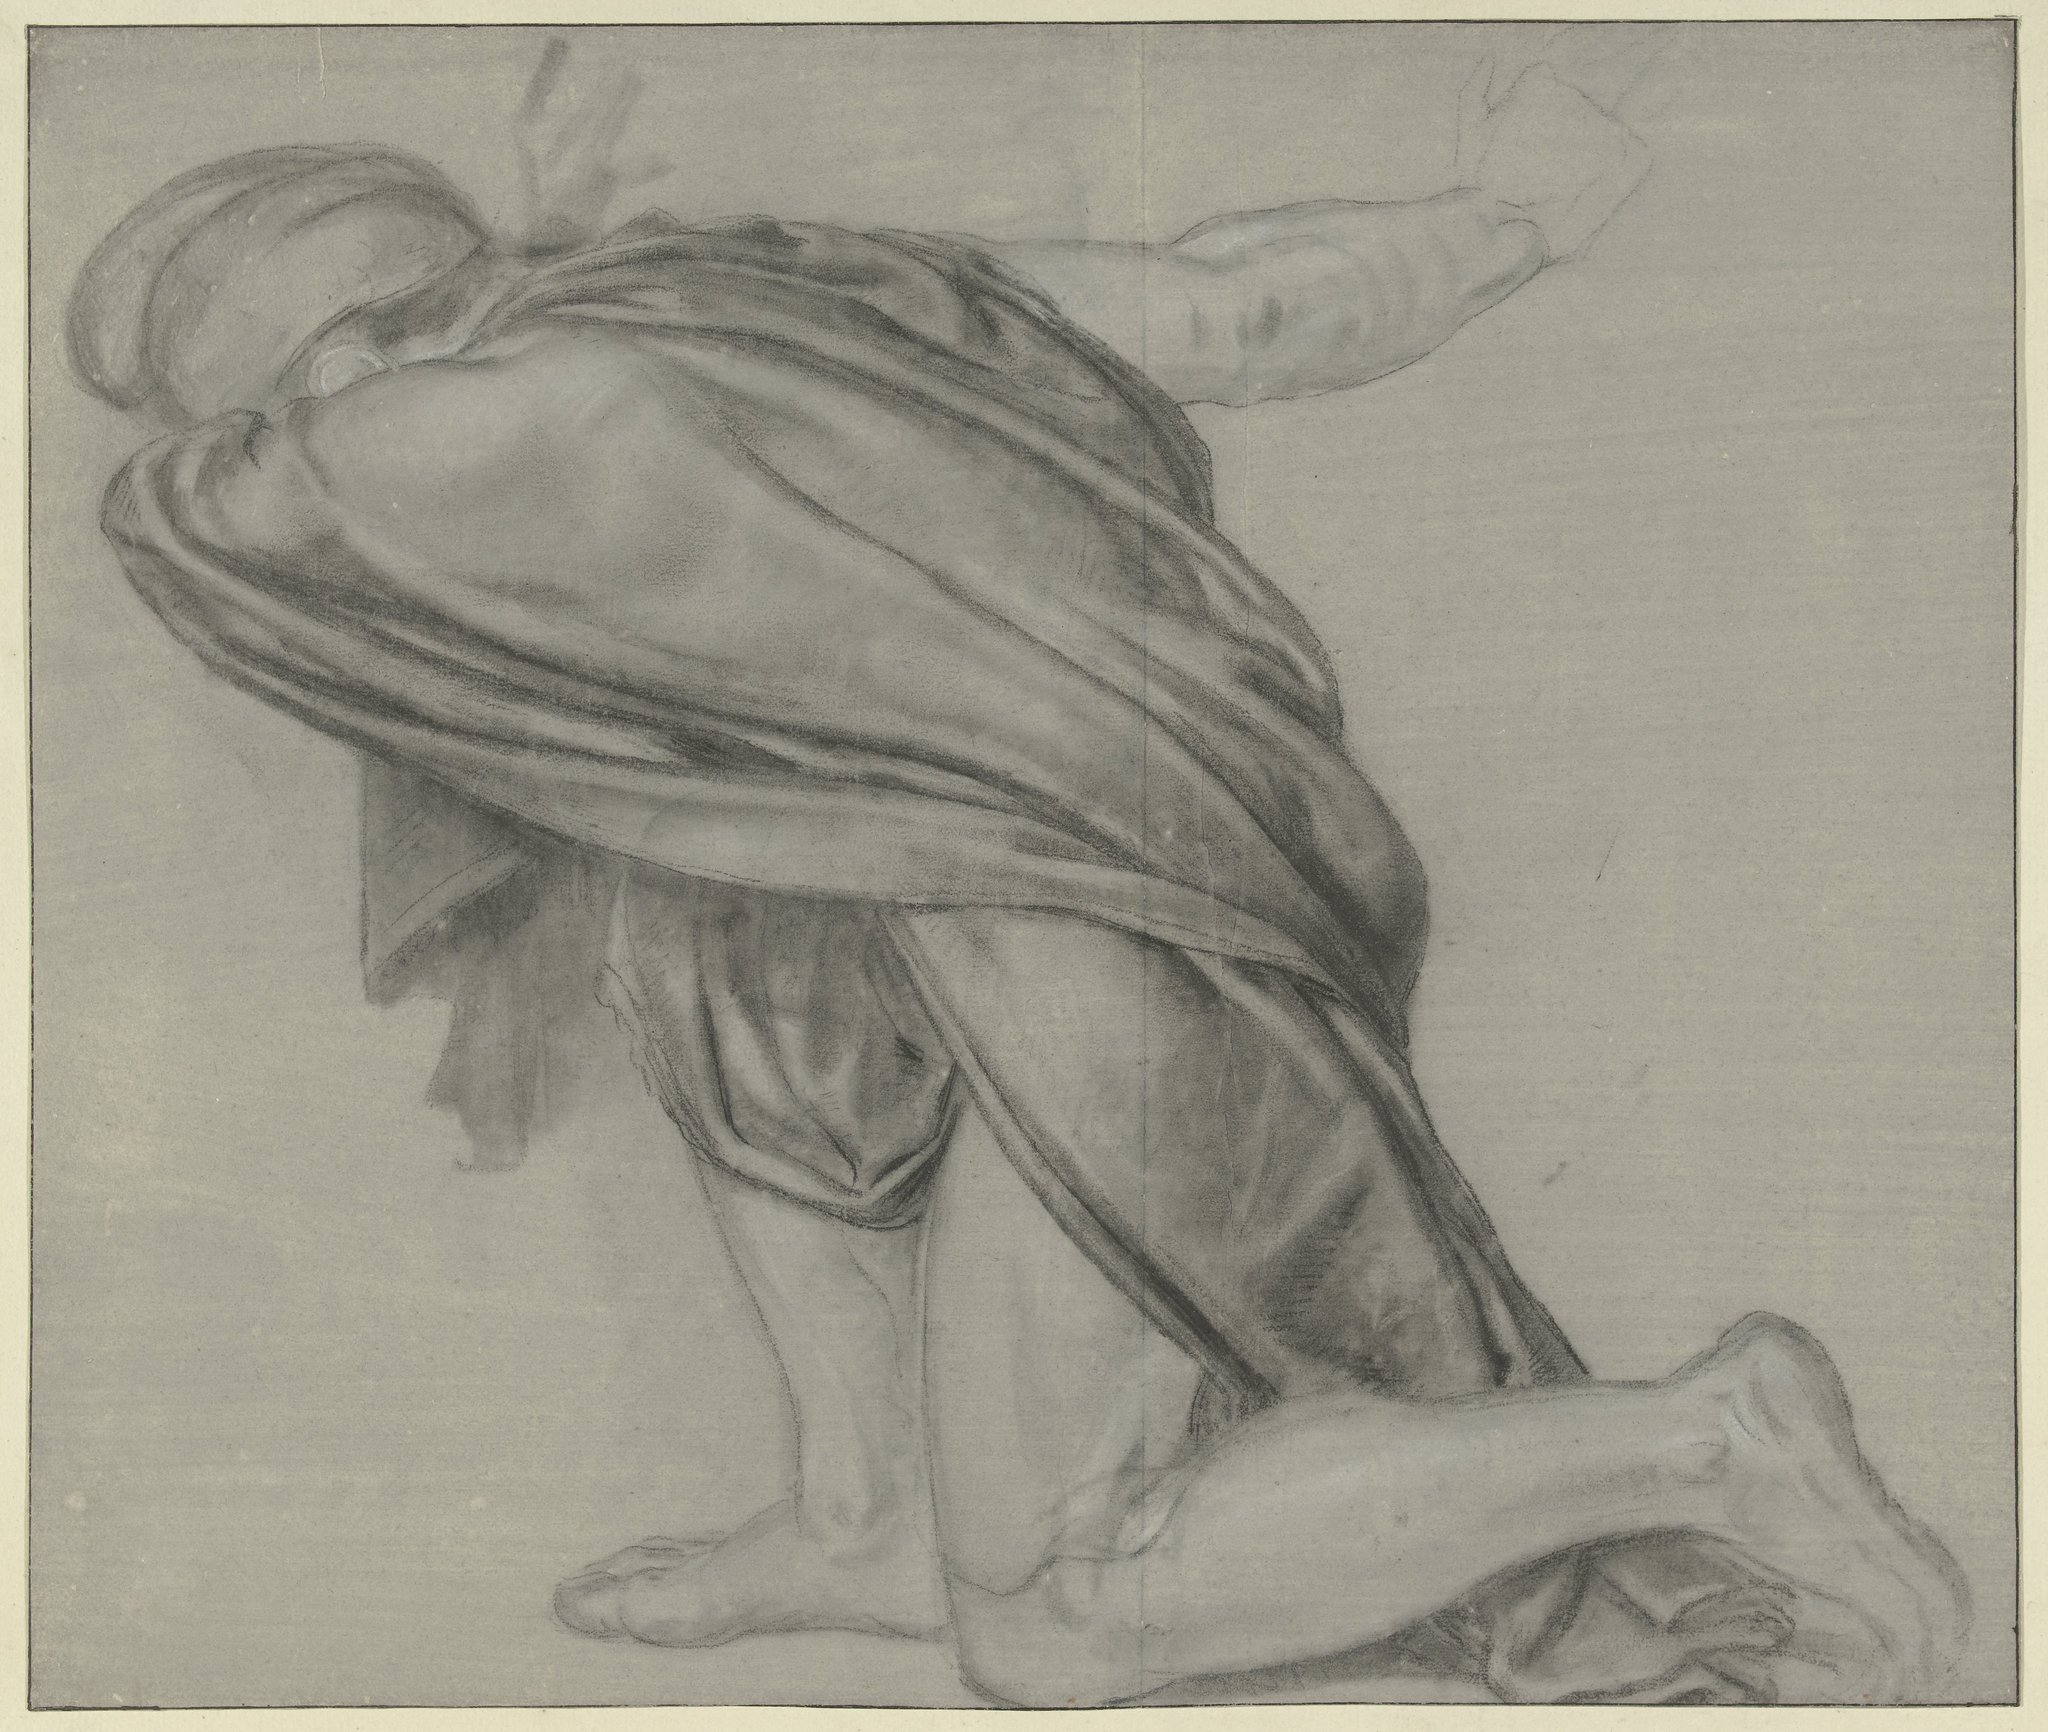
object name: drawing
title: Draperiestudie van knielende man, naar links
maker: jean grandjean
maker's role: draughtsman, print maker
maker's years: 1752-1781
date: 1765-1781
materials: chalk, paper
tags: drapery, draped garment, 'gewandgebung'